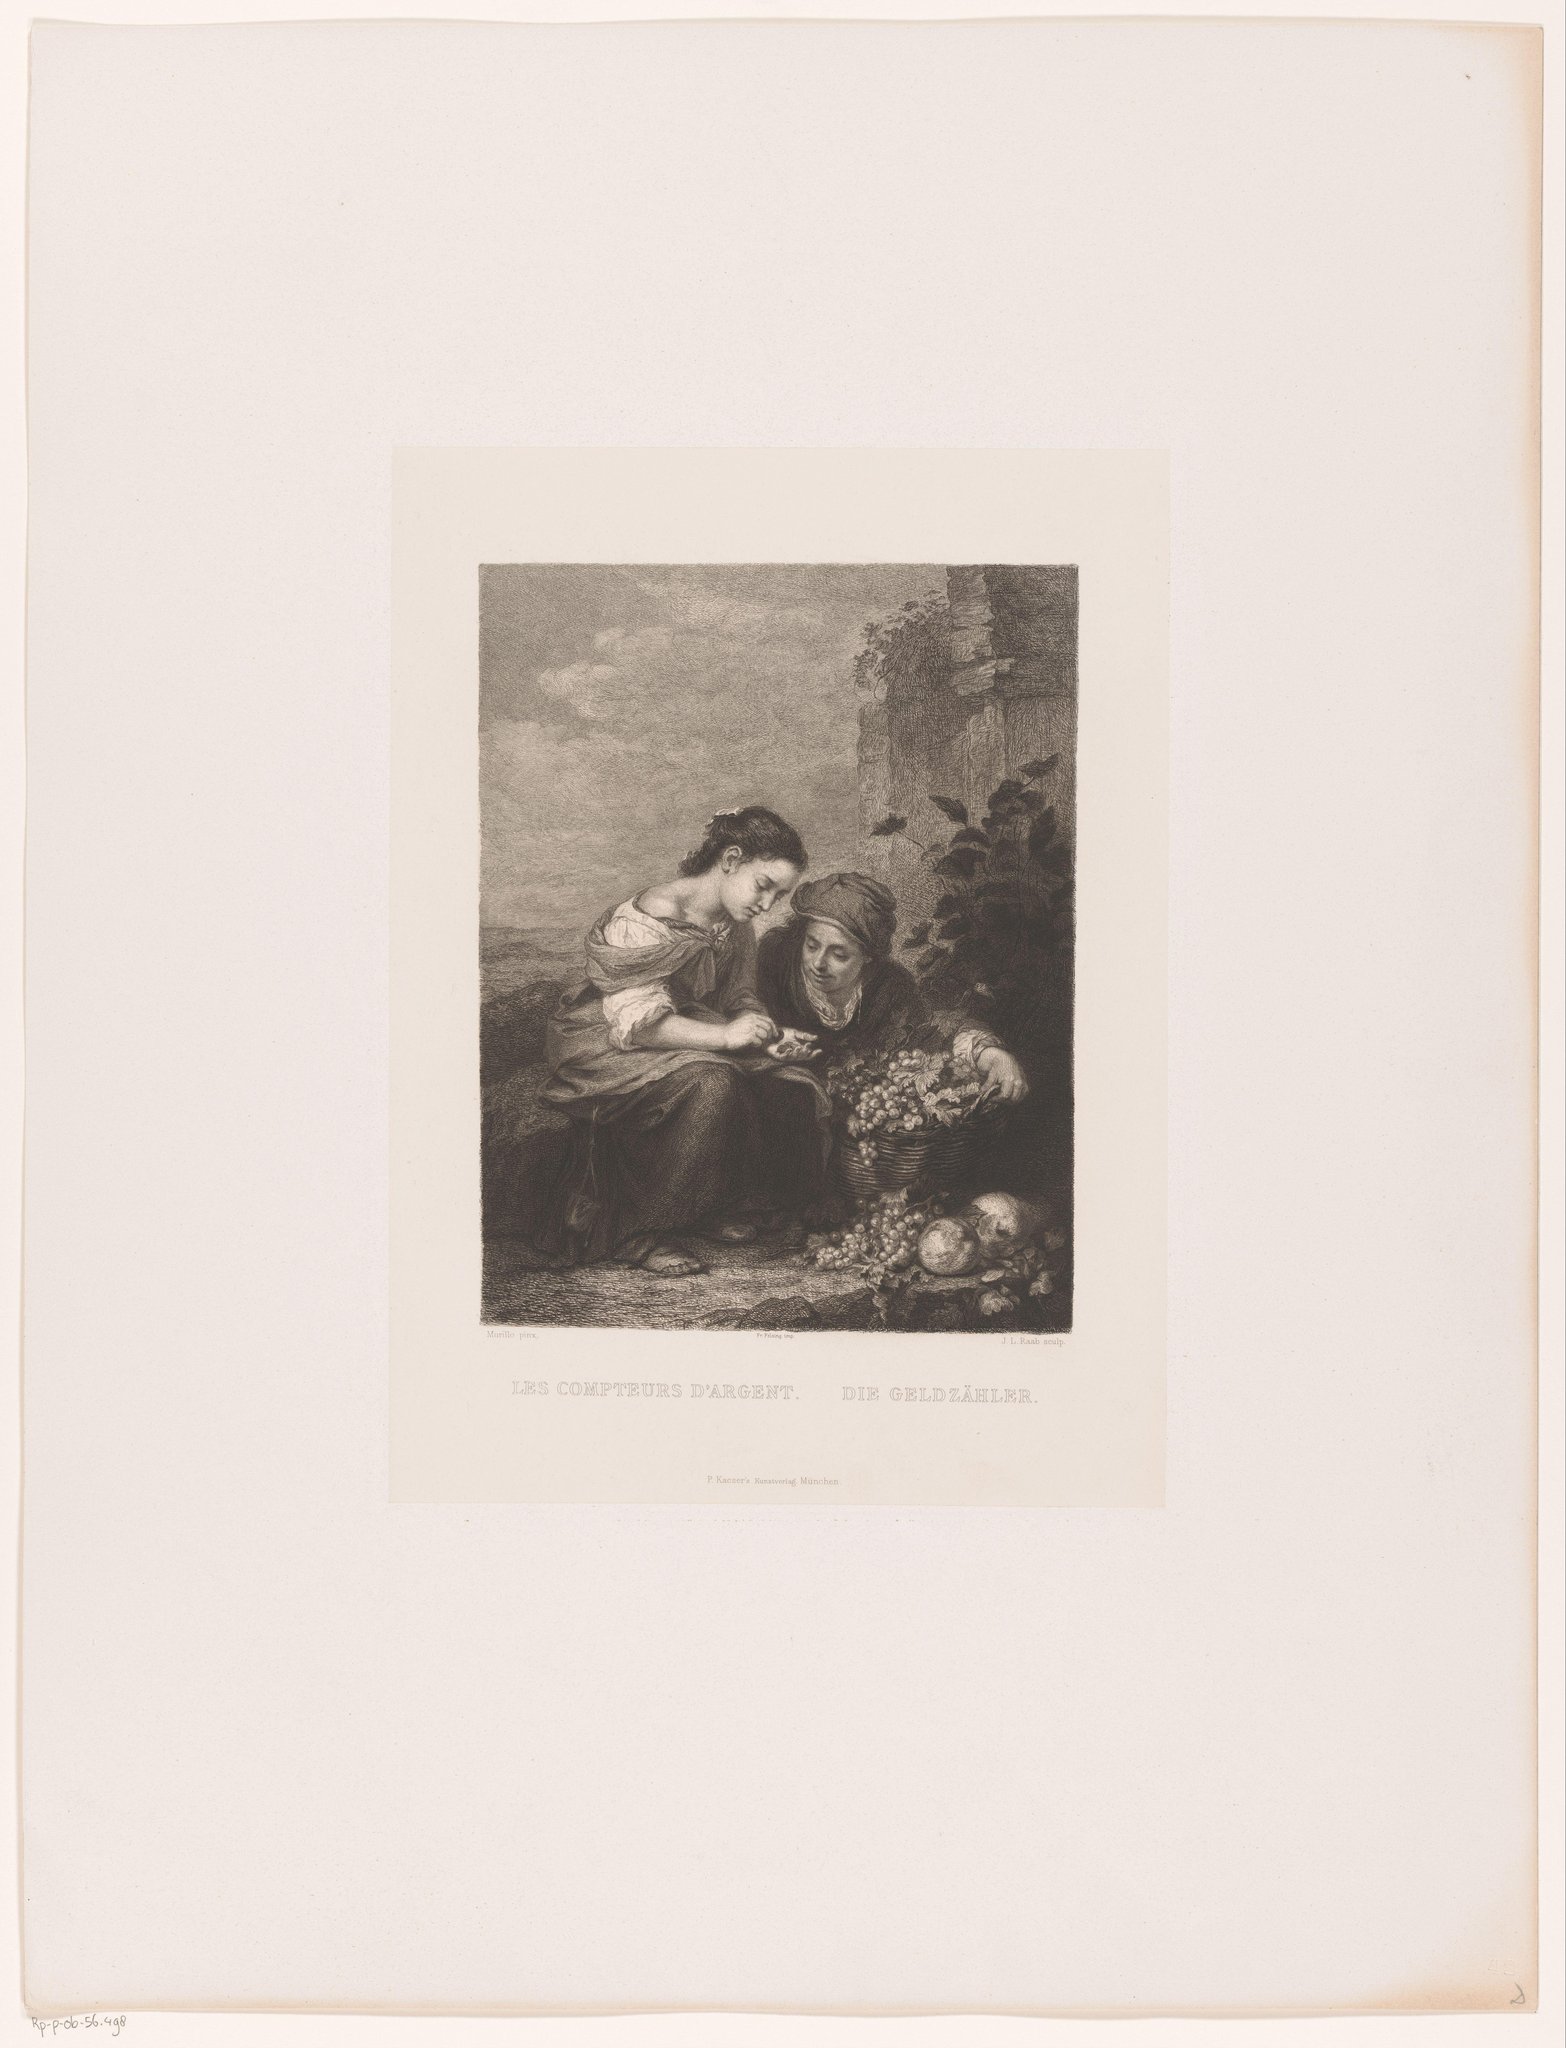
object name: print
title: Kinderen tellen geld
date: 1835-1899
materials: paper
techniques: etching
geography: munich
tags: money, counting, calculating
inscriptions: collector's mark: Lugt 2228, number: ‘42’